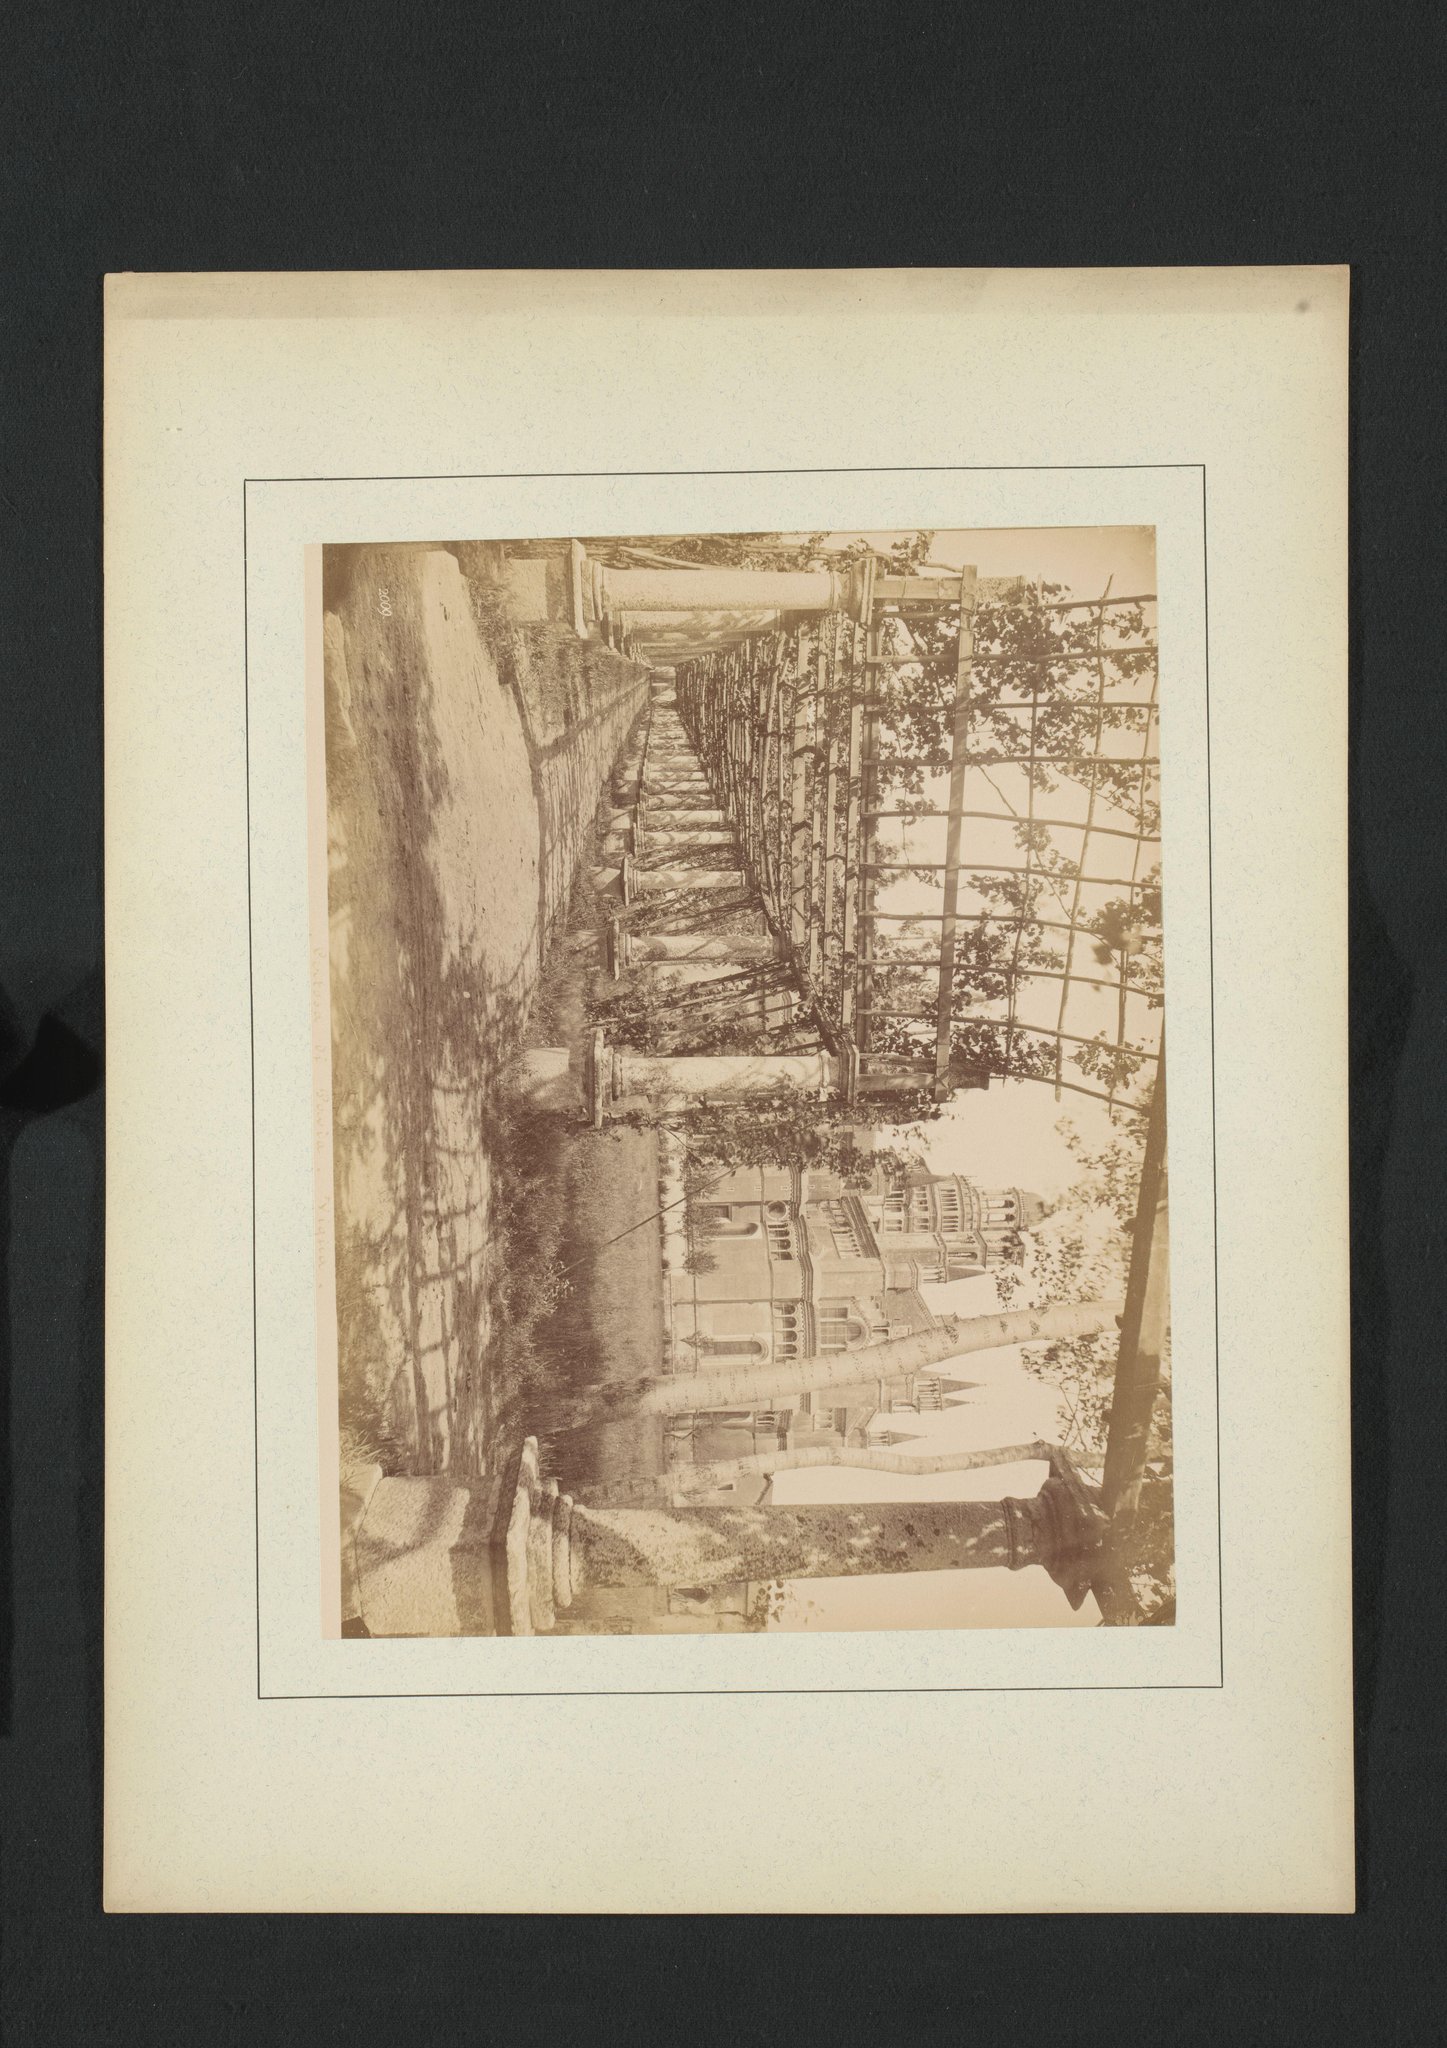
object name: photograph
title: Gezicht op de Certosa di Pavia met de wijngaard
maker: alfredo noack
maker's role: fotograaf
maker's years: 1833-1895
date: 1877-1882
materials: cardboard, photographic support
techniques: albumen print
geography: certosa di pavia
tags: vineyard, cloisters ~ monastery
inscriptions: number: ‘2009’, inscription: ‘No. 20. Weingarten.’